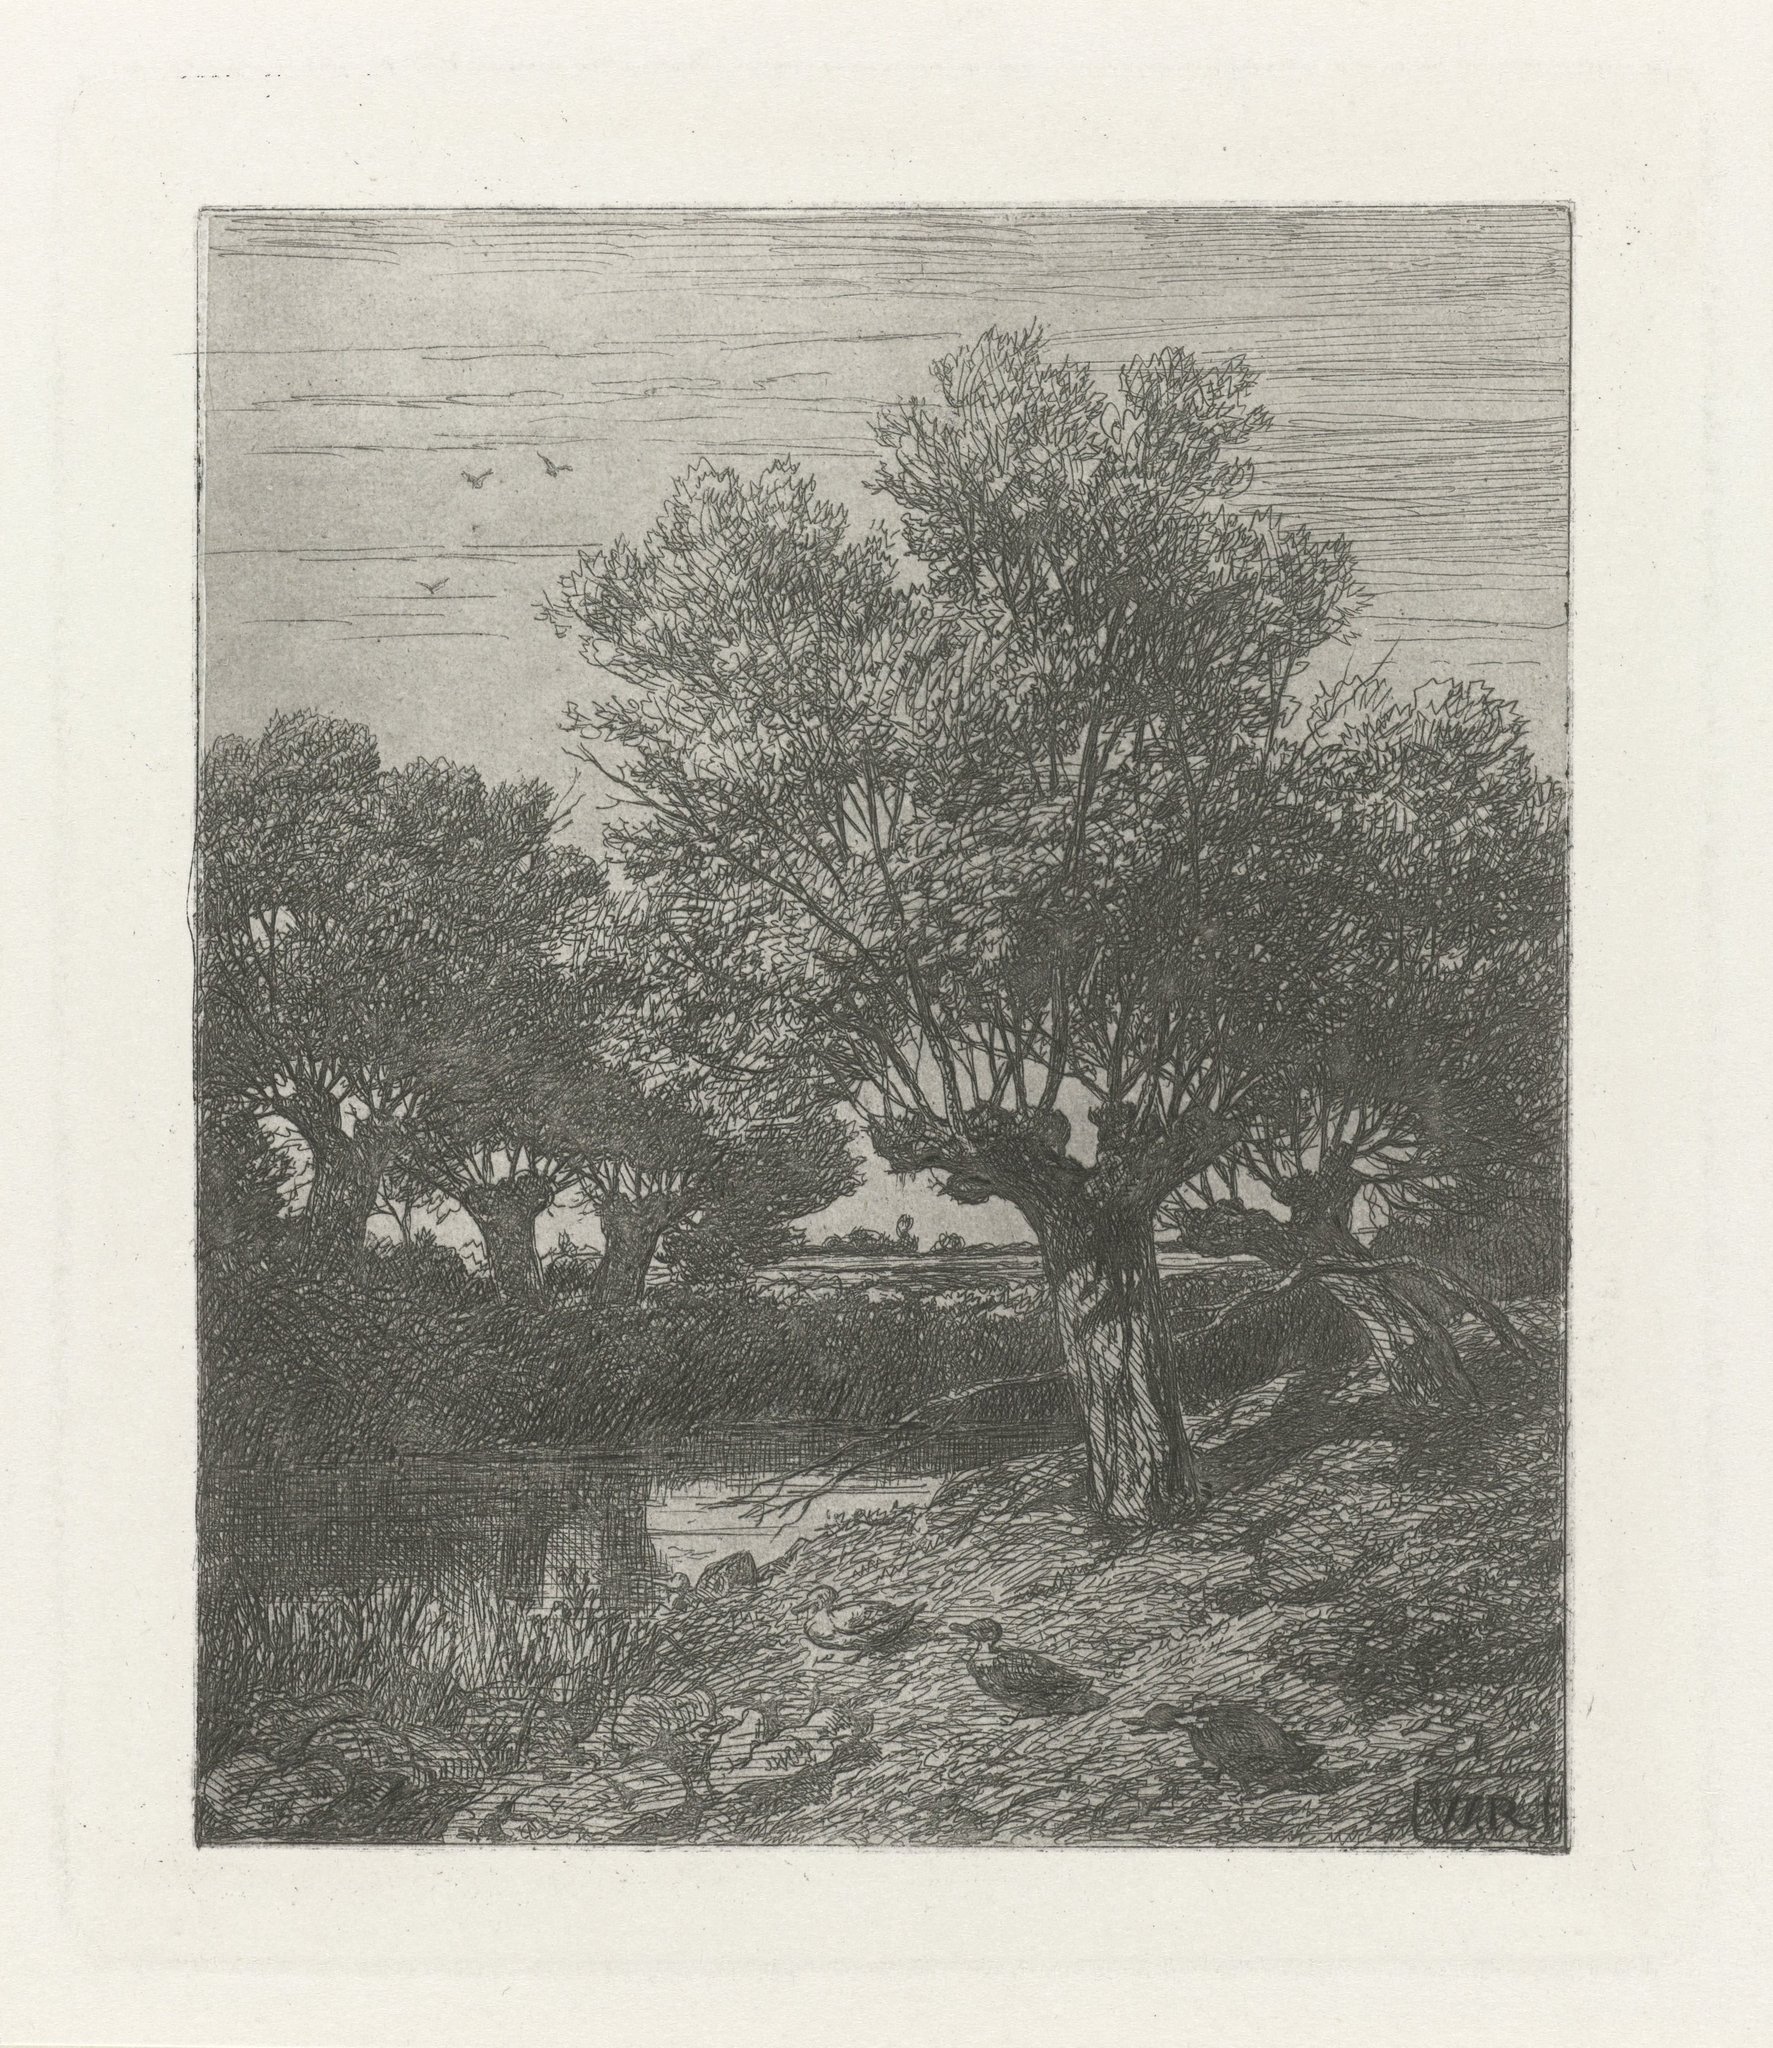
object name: print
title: Eenden bij een sloot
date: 1832-1897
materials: paper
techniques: drypoint, etching, intaglio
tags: trees: willow, small canal, ditch, water-birds: duck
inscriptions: collector's mark: Lugt 2228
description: Weidelandschap met knotwilgen aan waterkant van een sloot. Aan de rand van het water zitten vier eenden.